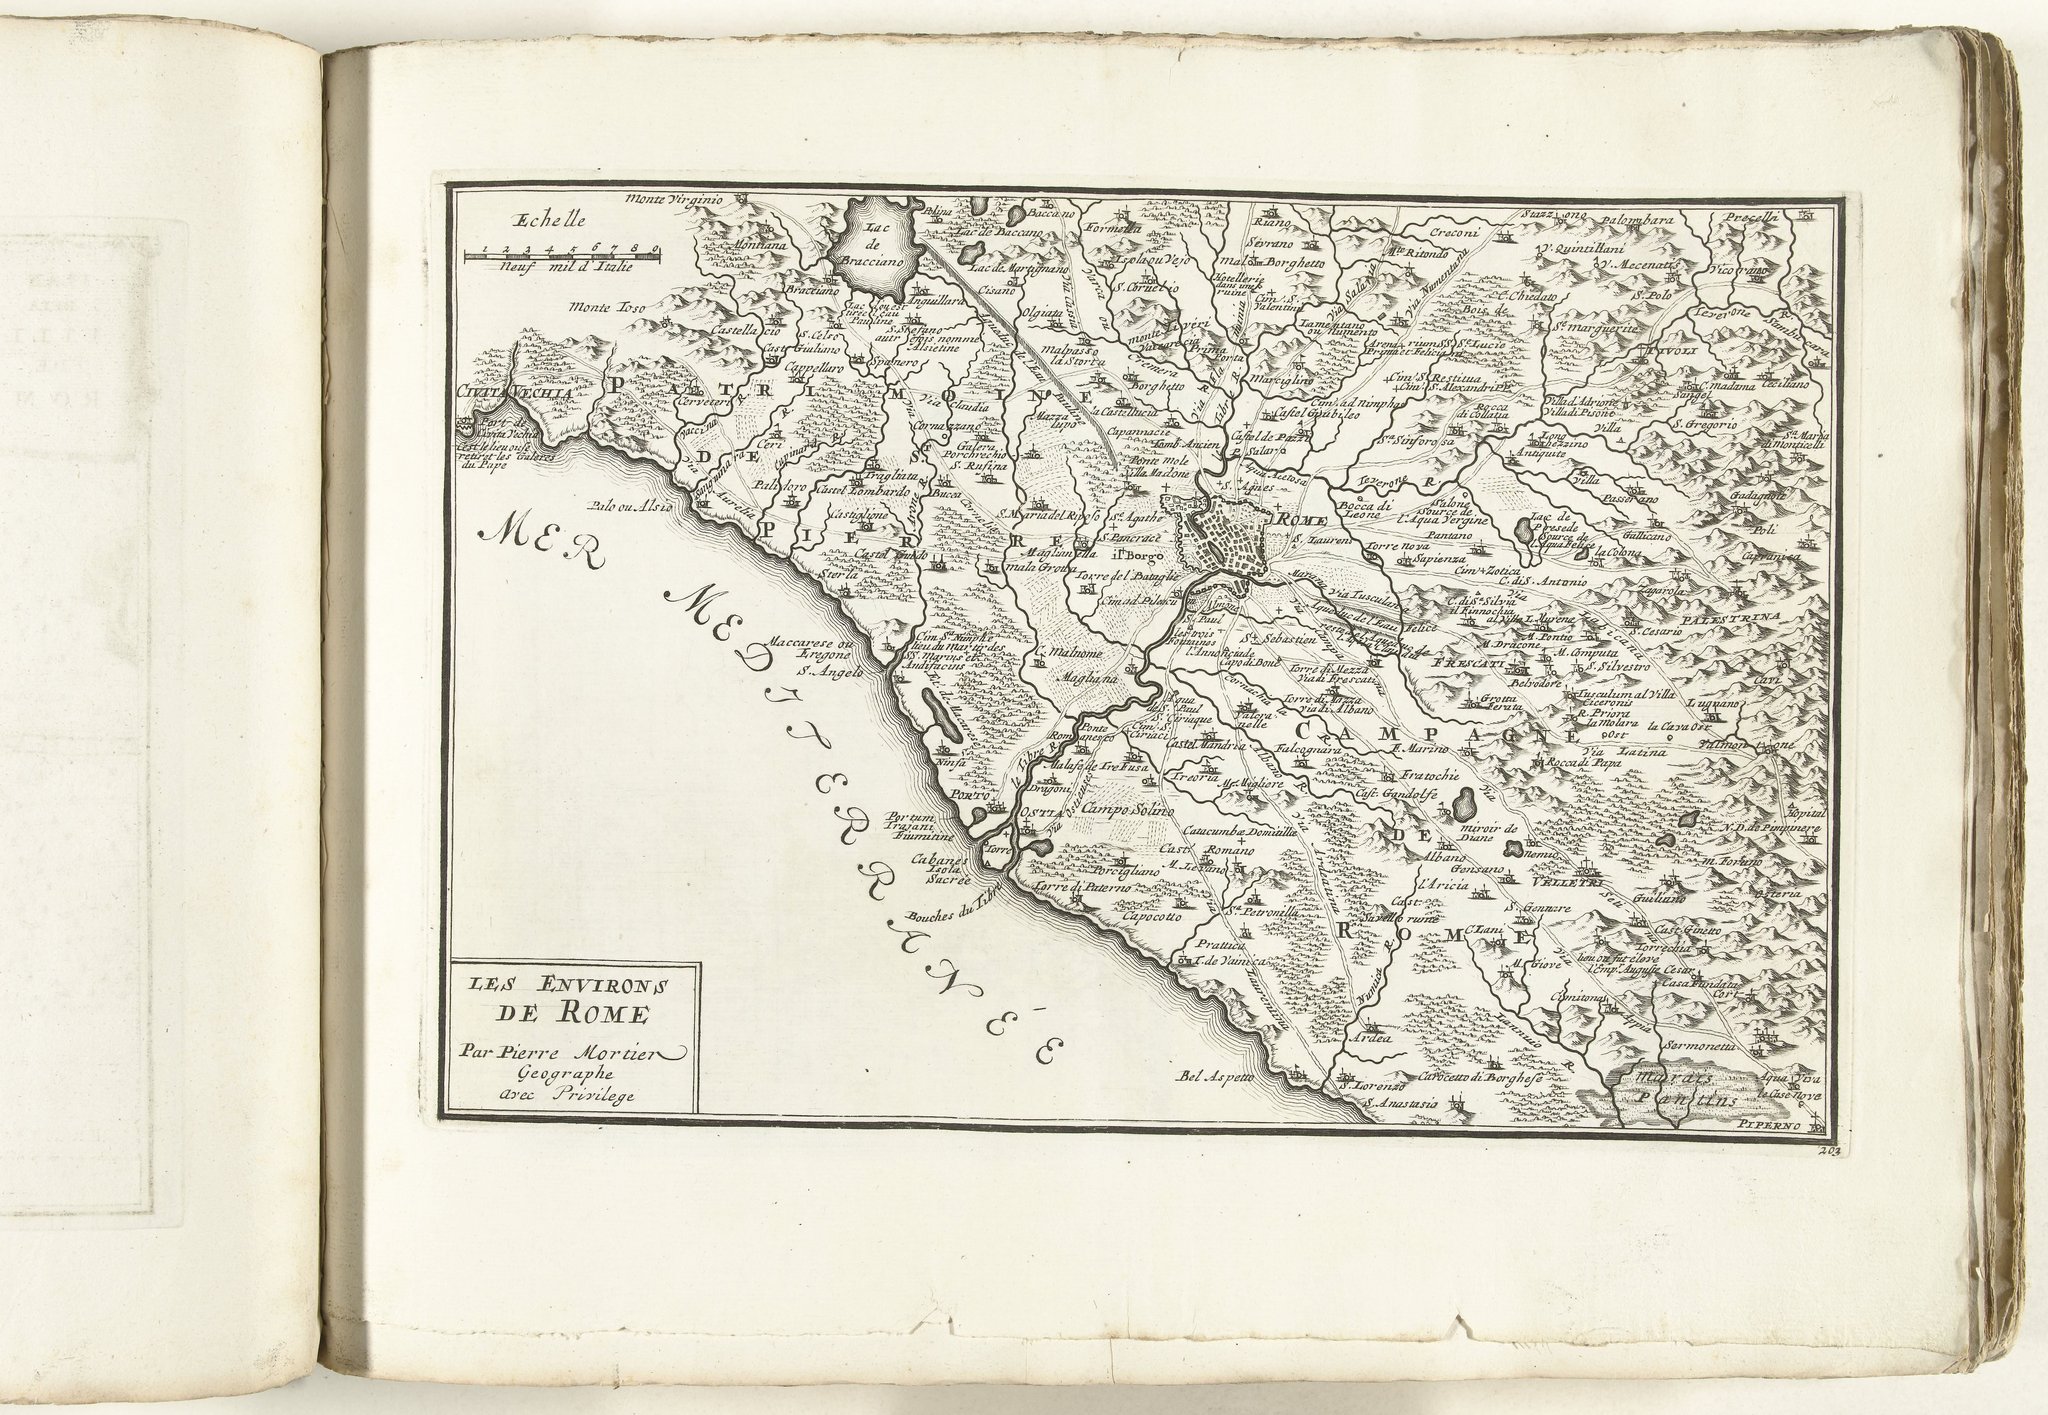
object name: map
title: Les Environs de Rome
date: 1702-1703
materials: paper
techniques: engraving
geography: amsterdam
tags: maps of separate countries or regions, italy, rome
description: Kaart van Rome en omgeving. Plaat nr. 203 in het prentwerk bestaande in totaal uit 276 genummerde platen van vermaarde sterke steden en vestingen in het kader van de Spaanse Successieoorlog. Voor het merendeel zijn deze platen gekopieerd naar de anonieme Franse platen: in Les forces de l'Europe en in: Le theatre de la guerre, dans les Pays-Bas, beide oorspronkelijk uitgegeven door Nicolas de Fer te Parijs (1693-1697) in het kader van de Negenjarige Oorlog. Titel en opschriften in de plaat in het Frans.